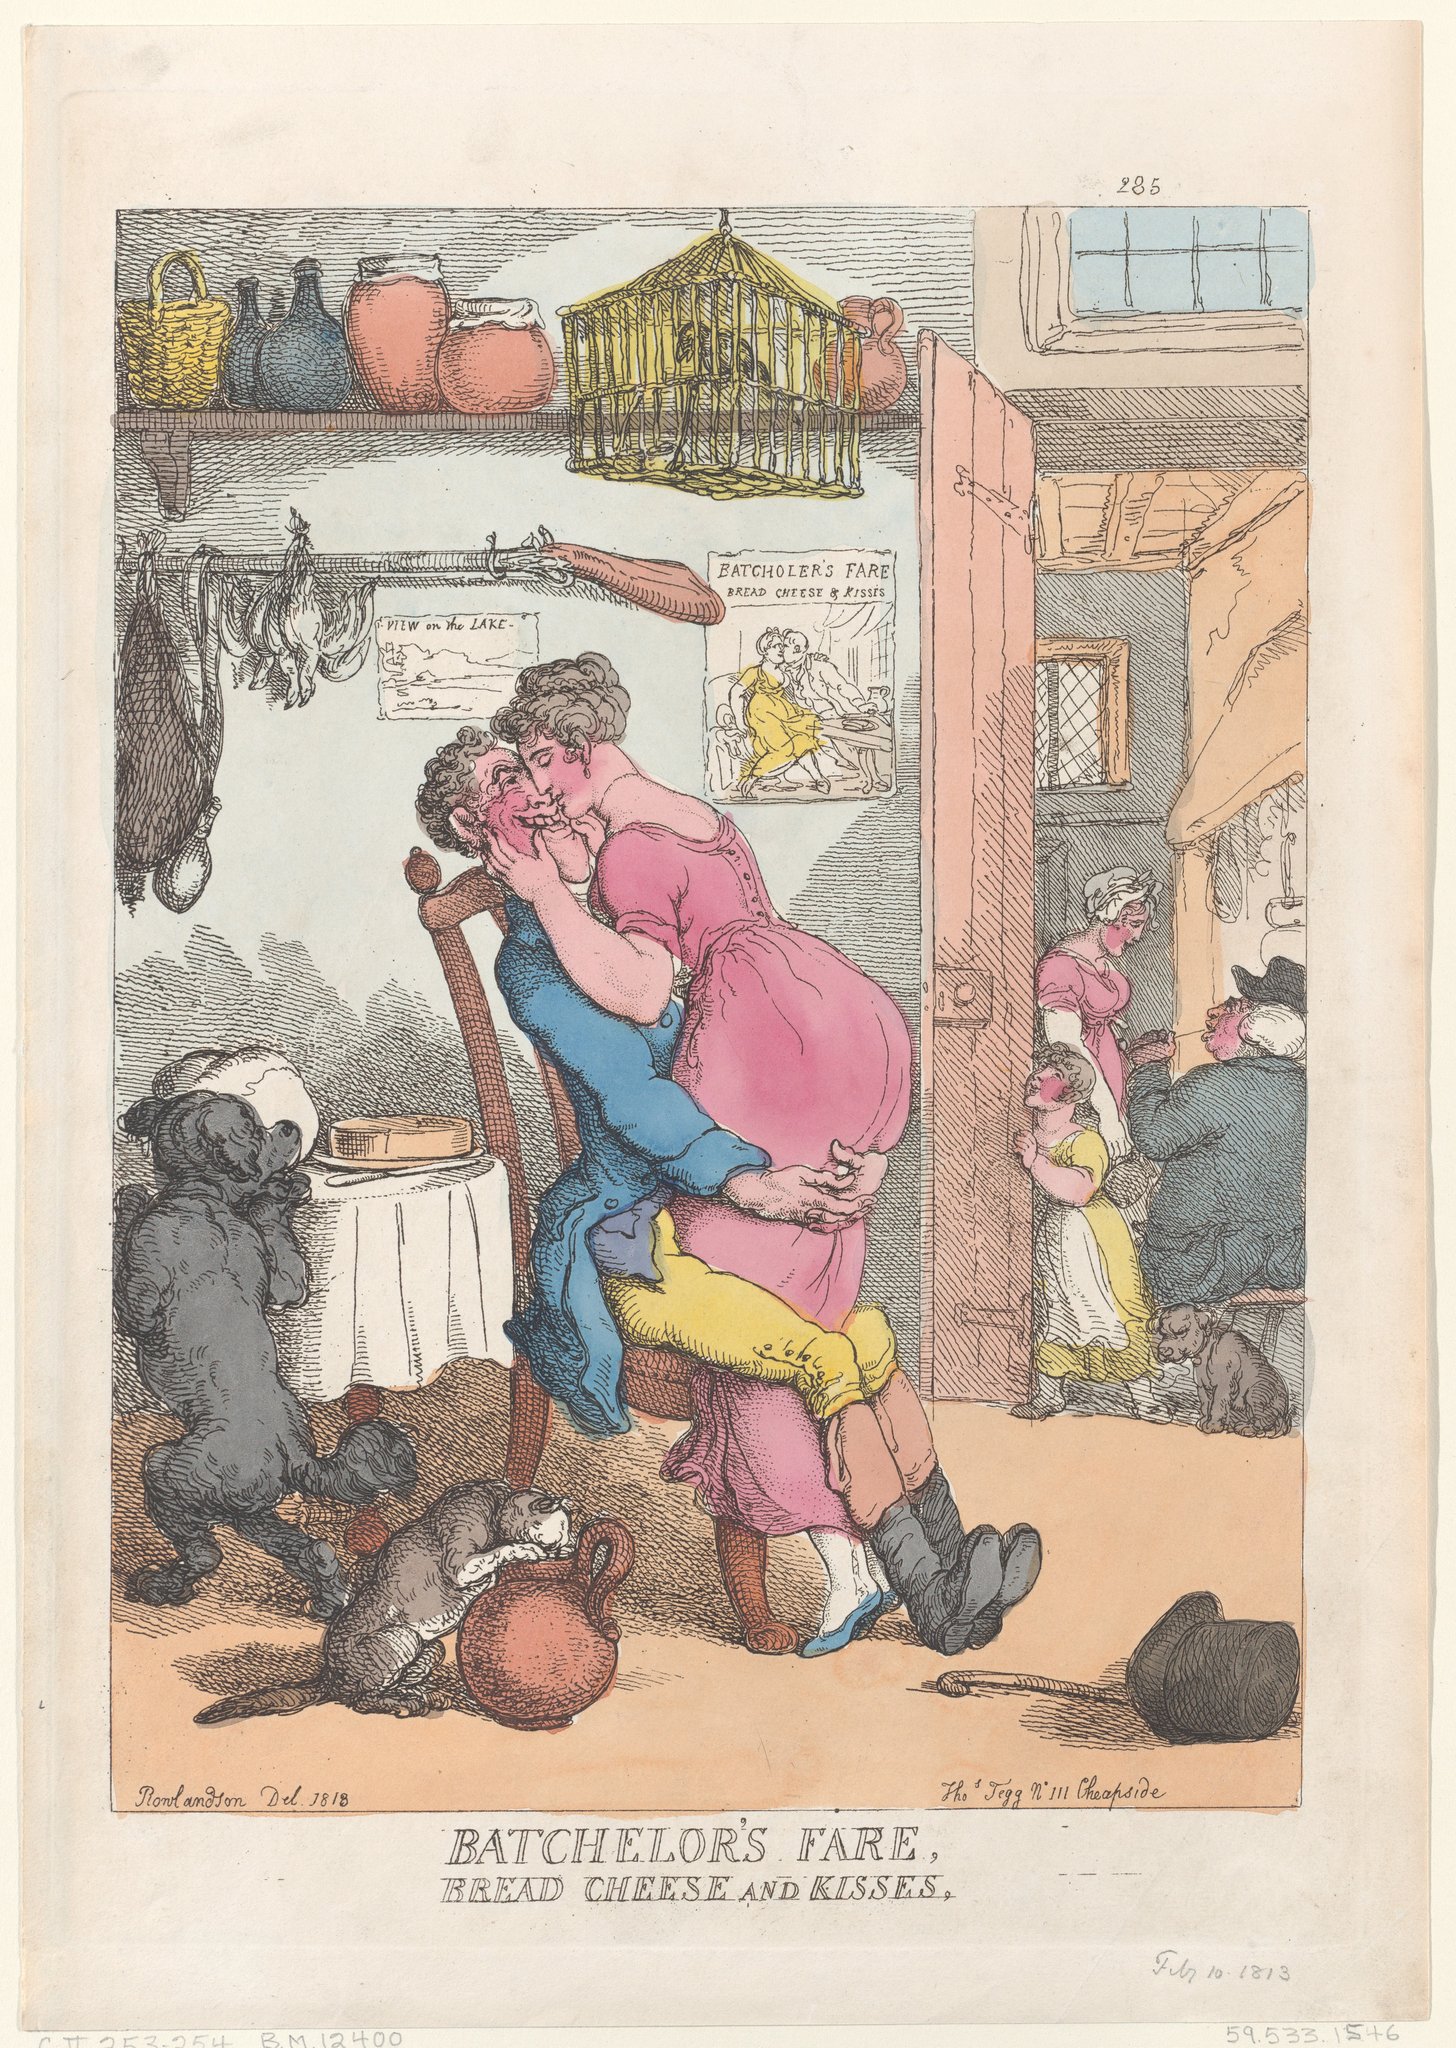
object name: print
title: Bachelor's Fare, Bread, Cheese, and Kisses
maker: thomas rowlandson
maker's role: artist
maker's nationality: british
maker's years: 1757-1827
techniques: etching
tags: satire,couples,men,women,dogs